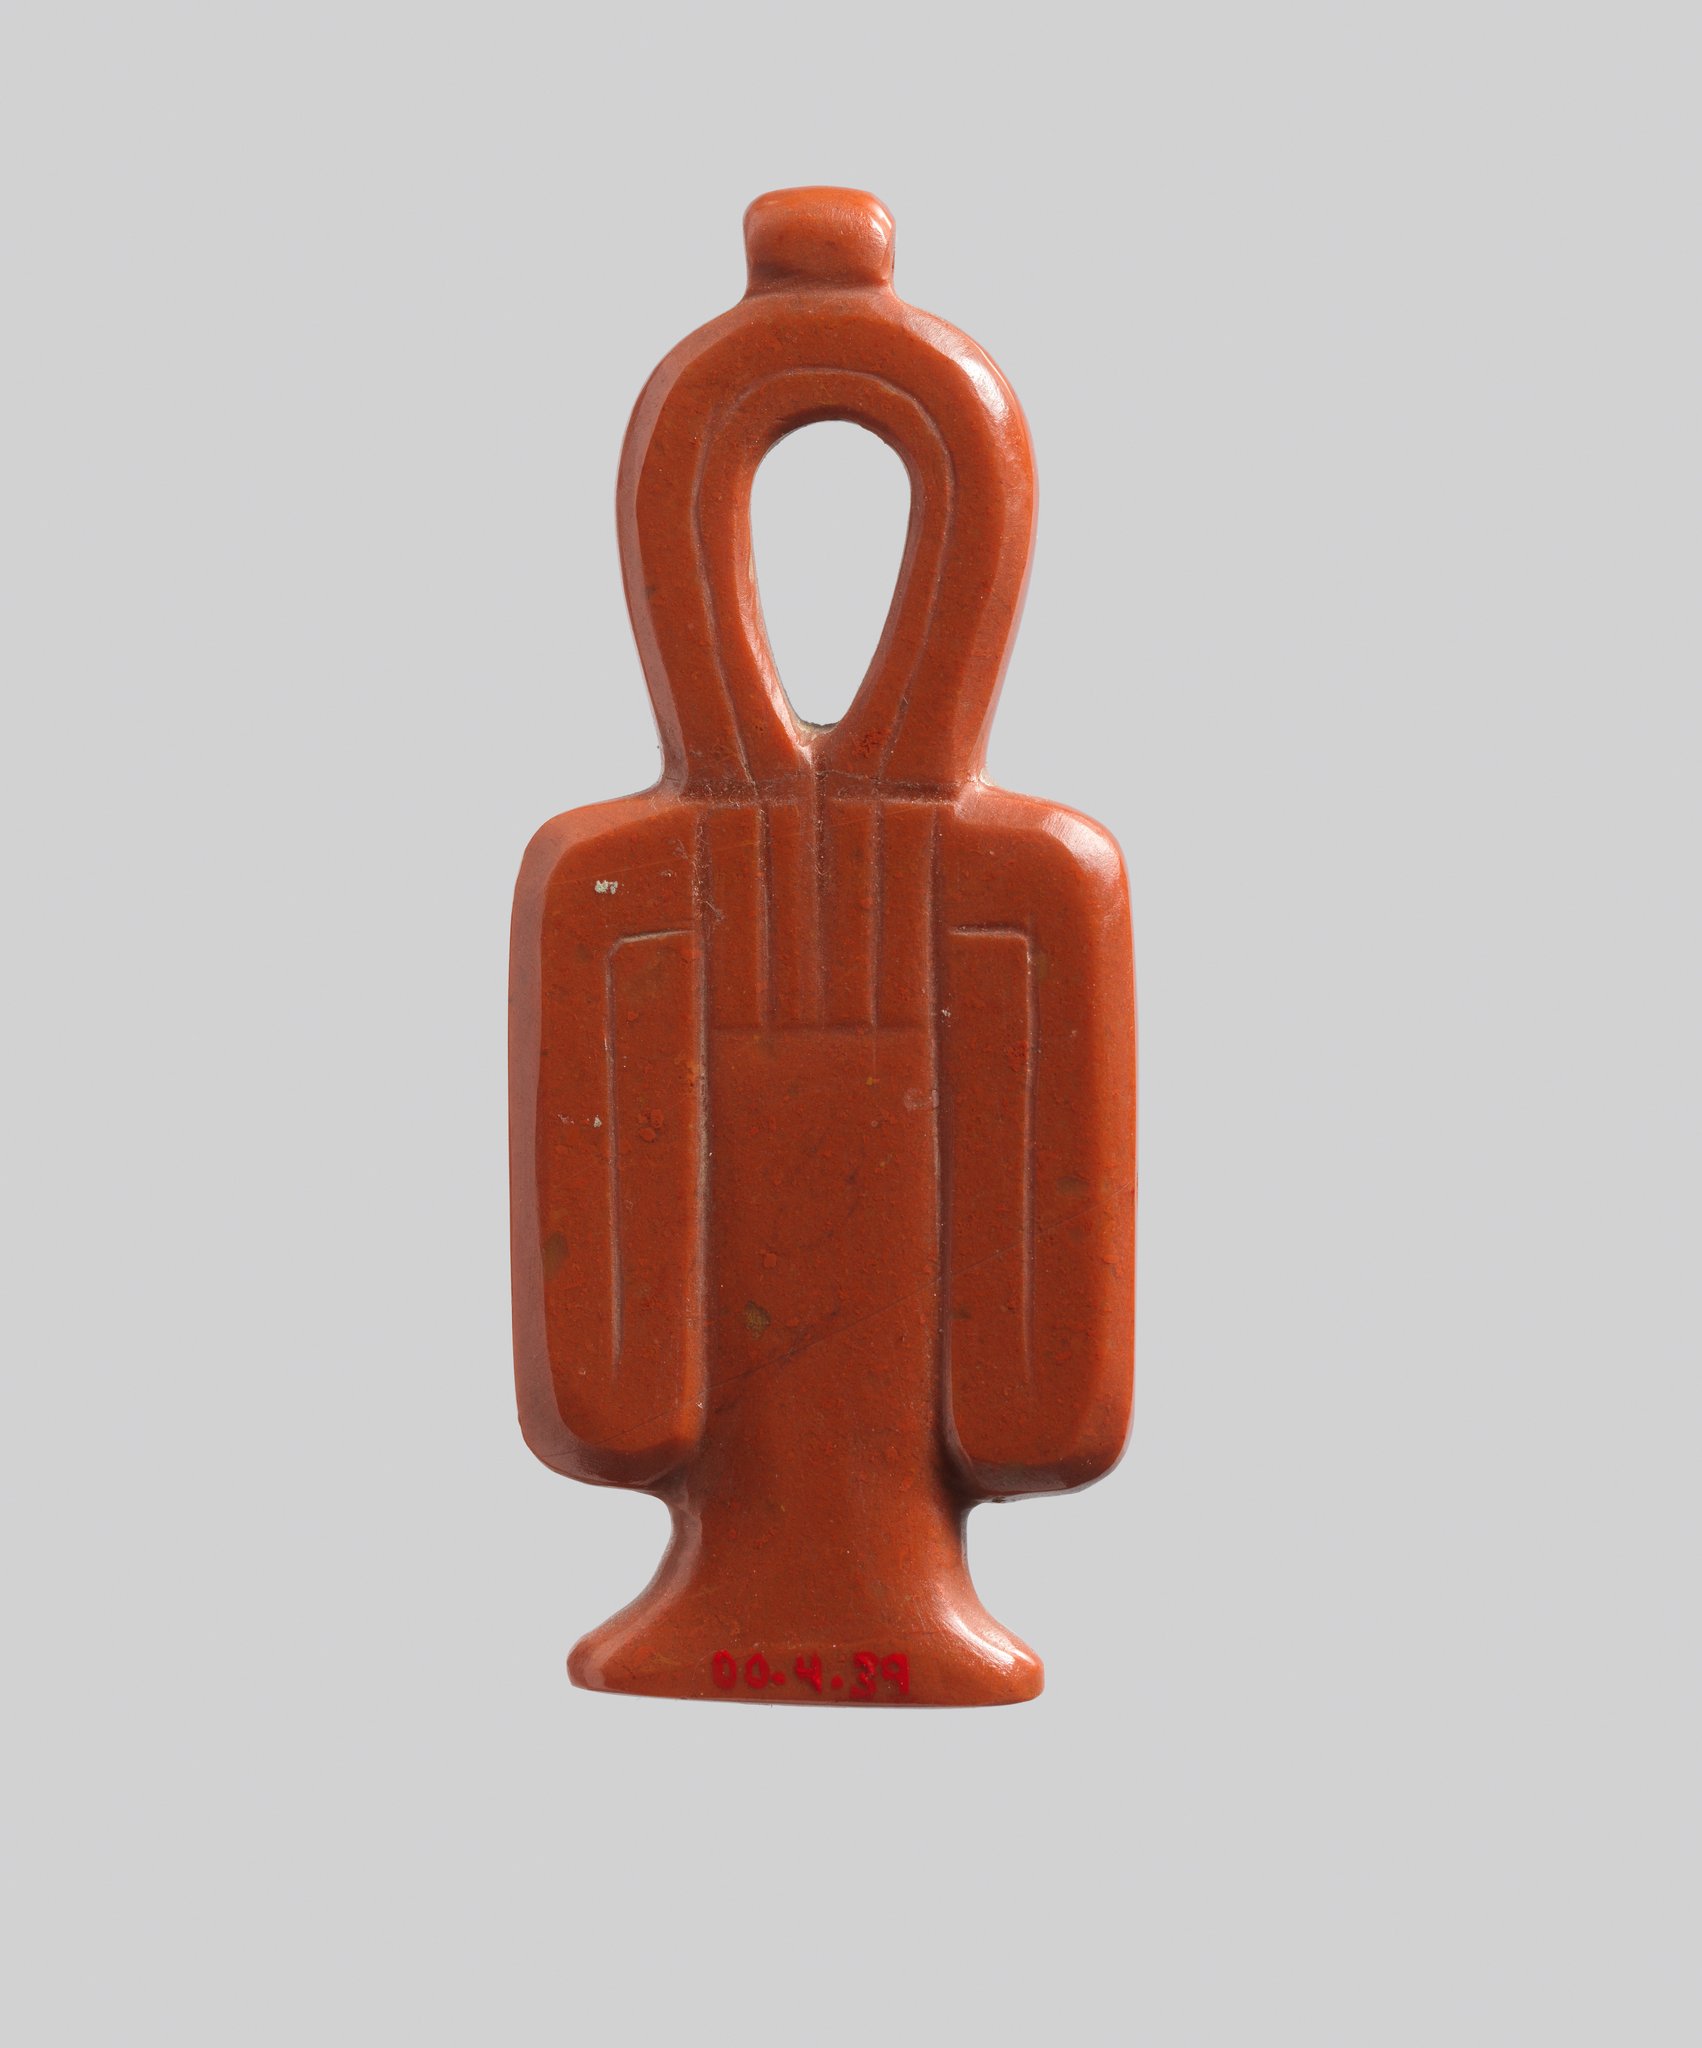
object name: amulet, tit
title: Tit amulet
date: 1550-1070 BCE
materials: jasper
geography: egypt